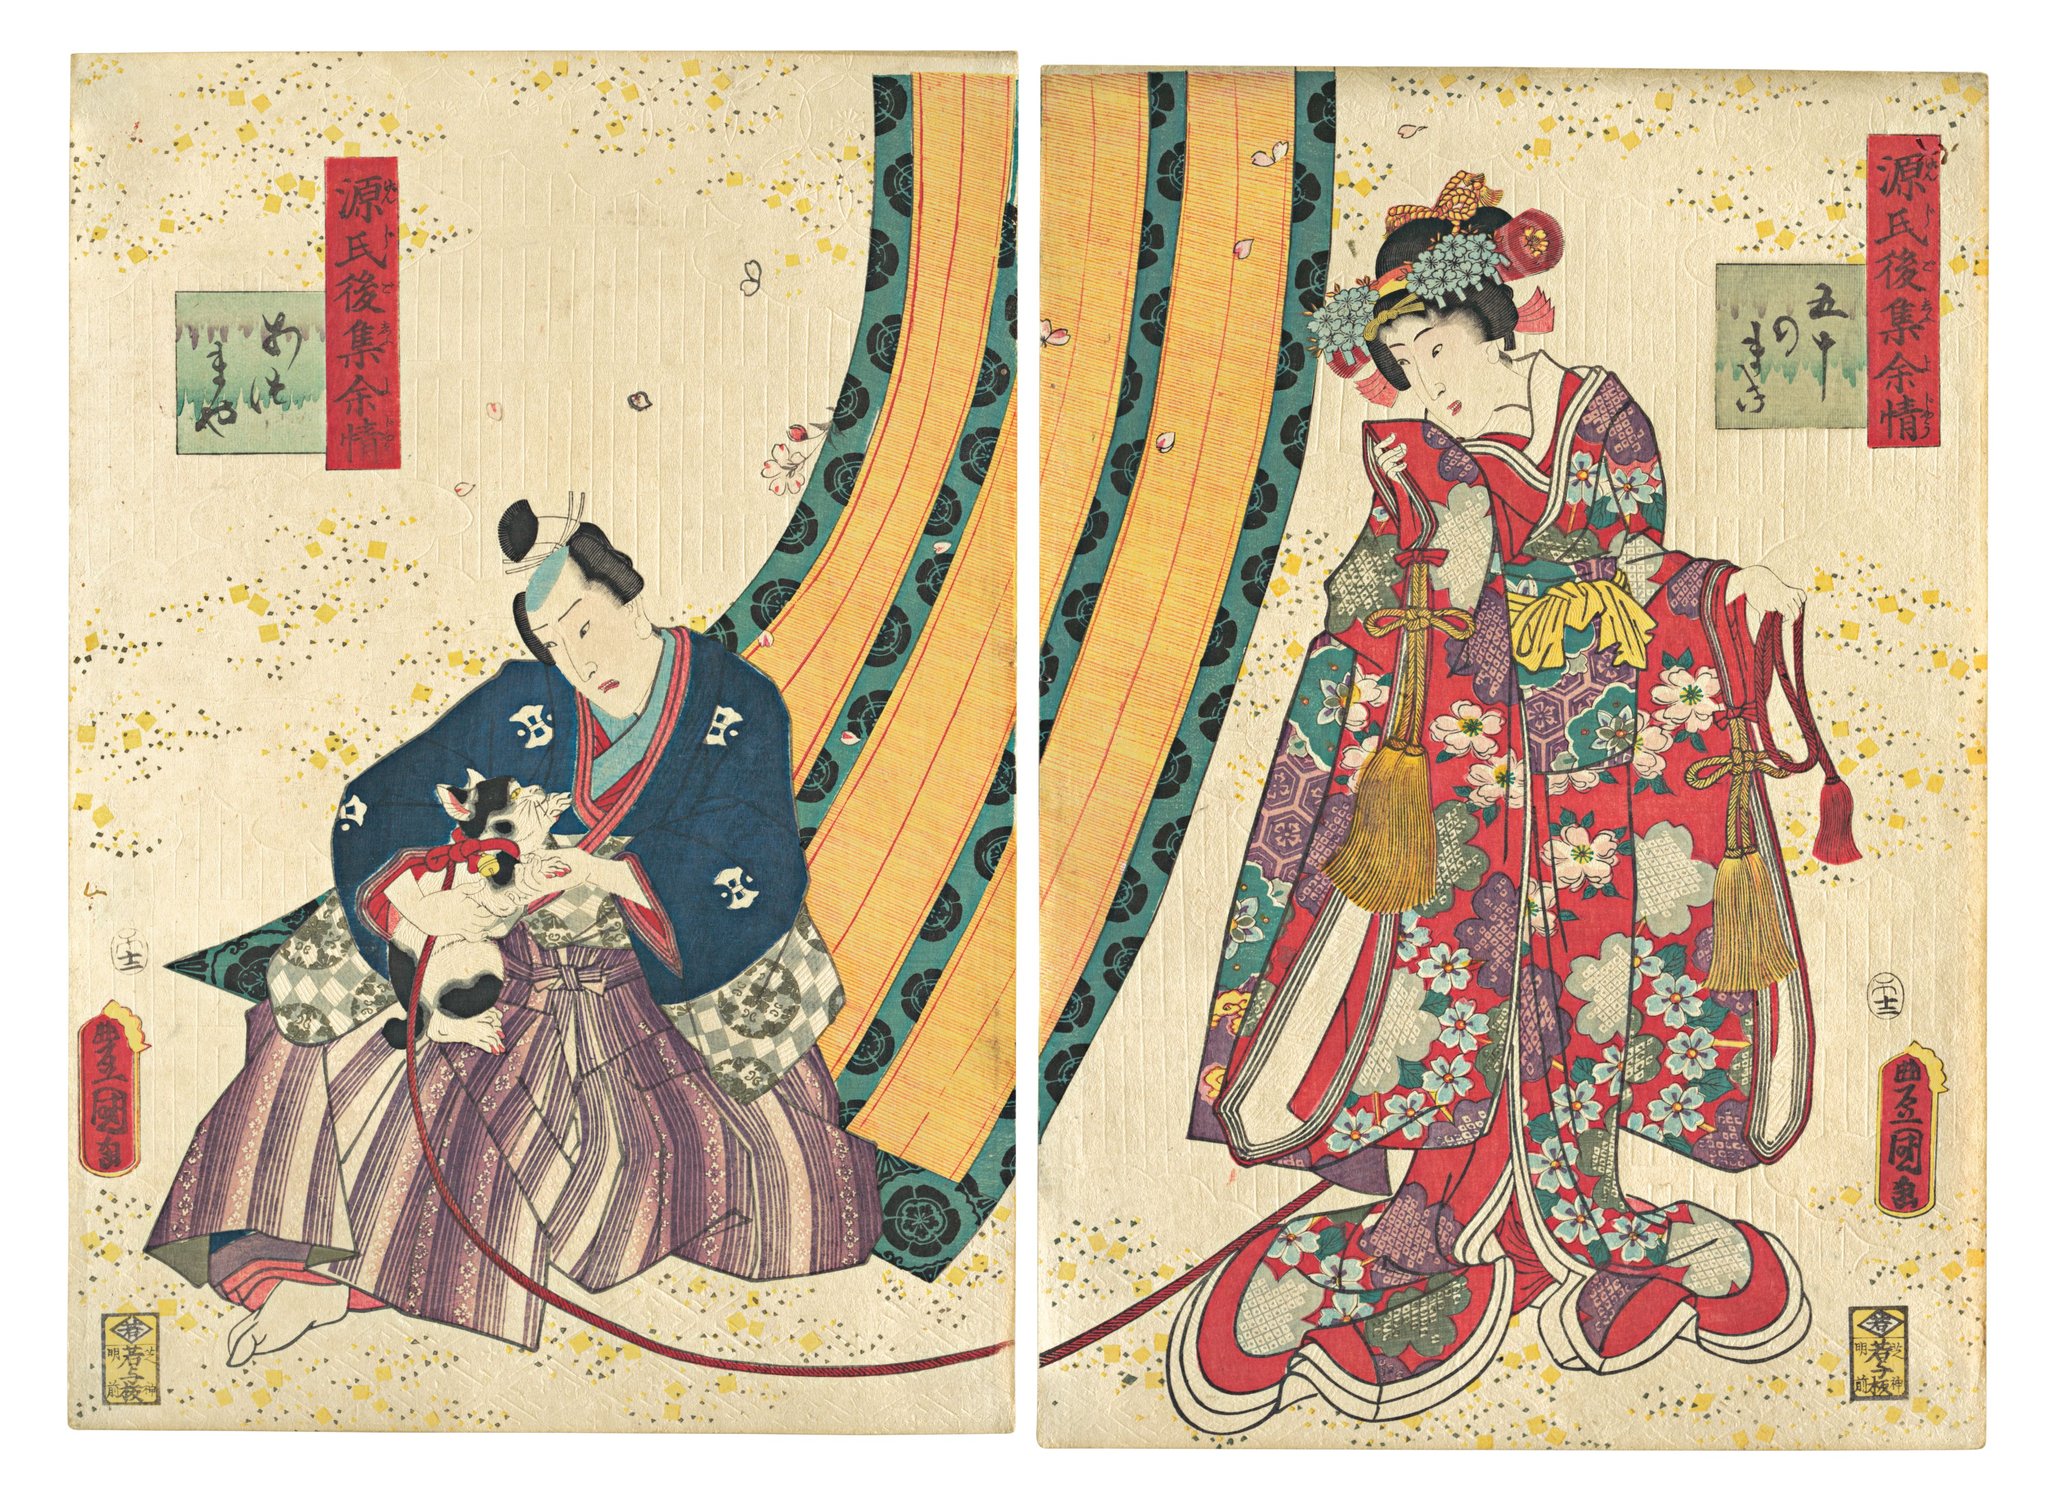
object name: print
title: Parody of the Third Princess and Kashiwagi: “Chapter 50: A Hut in the Eastern Provinces”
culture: japanese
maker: utagawa kunisada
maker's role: artist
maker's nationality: japanese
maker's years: 1786-1864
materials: ink, paper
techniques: woodblock print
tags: men,women,cats